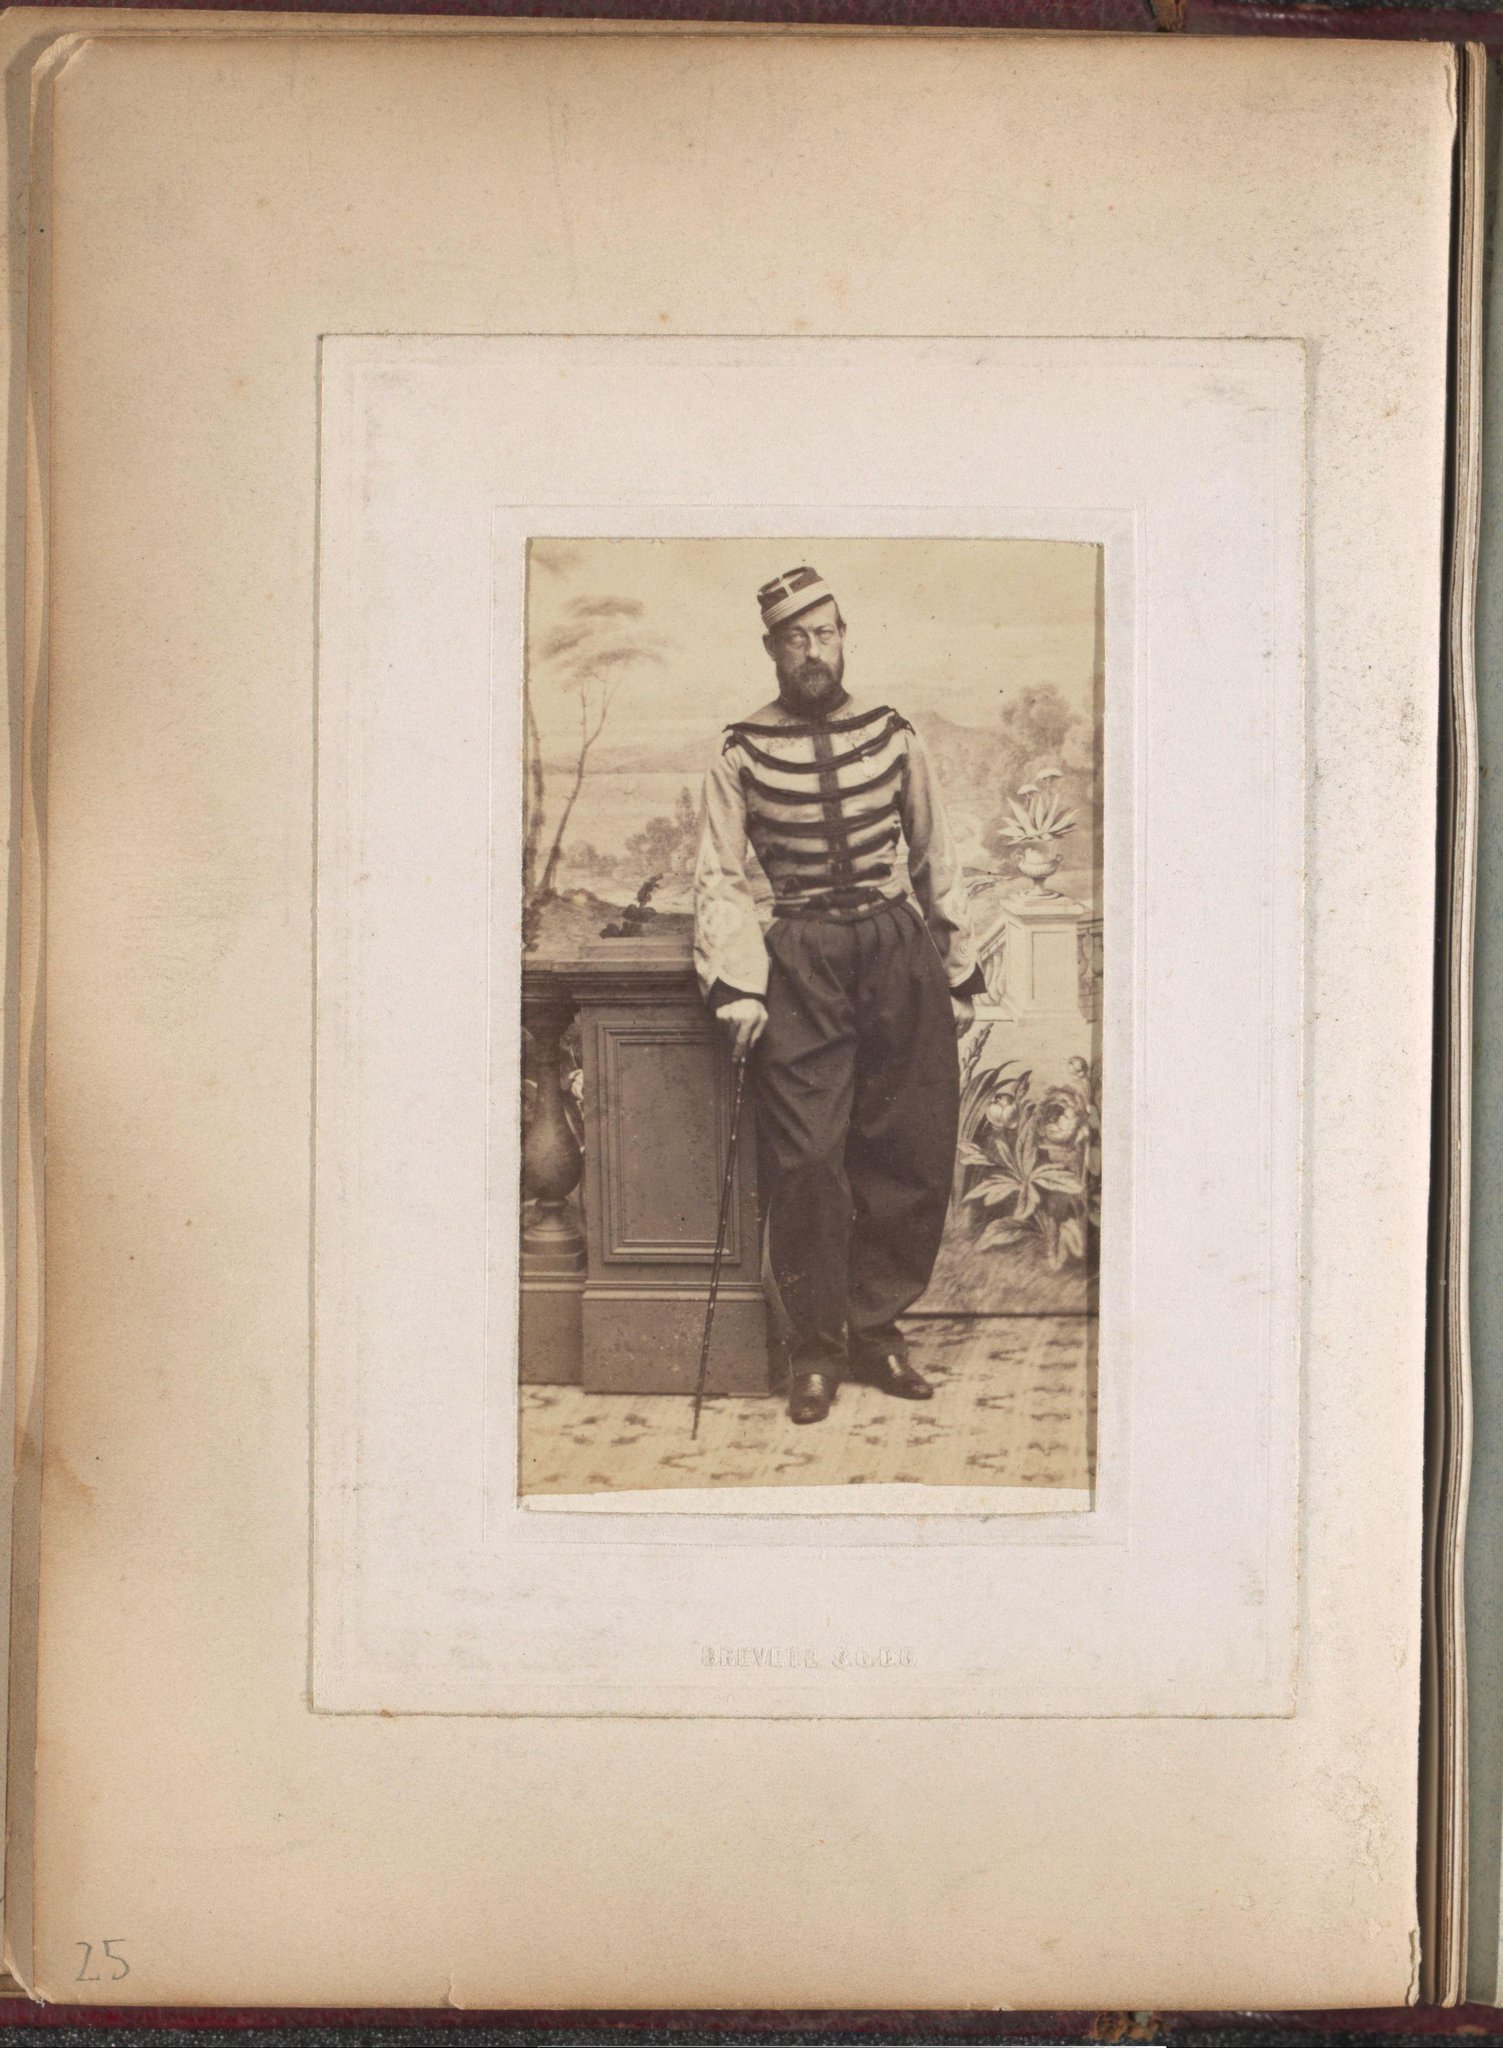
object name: photograph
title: Portret van een militair in een wijde broek en een gestreept hemd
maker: Anonymous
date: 1860-1865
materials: cardboard, paper, photographic support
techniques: albumen print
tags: studio requisites ~ photographer, trousers, breeches, walking-stick, staff, historical persons, clothing for the upper part of the body, head-gear: cap, shoes, sandals, (military) uniforms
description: Onderdeel van Fotoalbum met 48 cartes-de-visite aangeboden aan maarschalk graaf De Castellane.